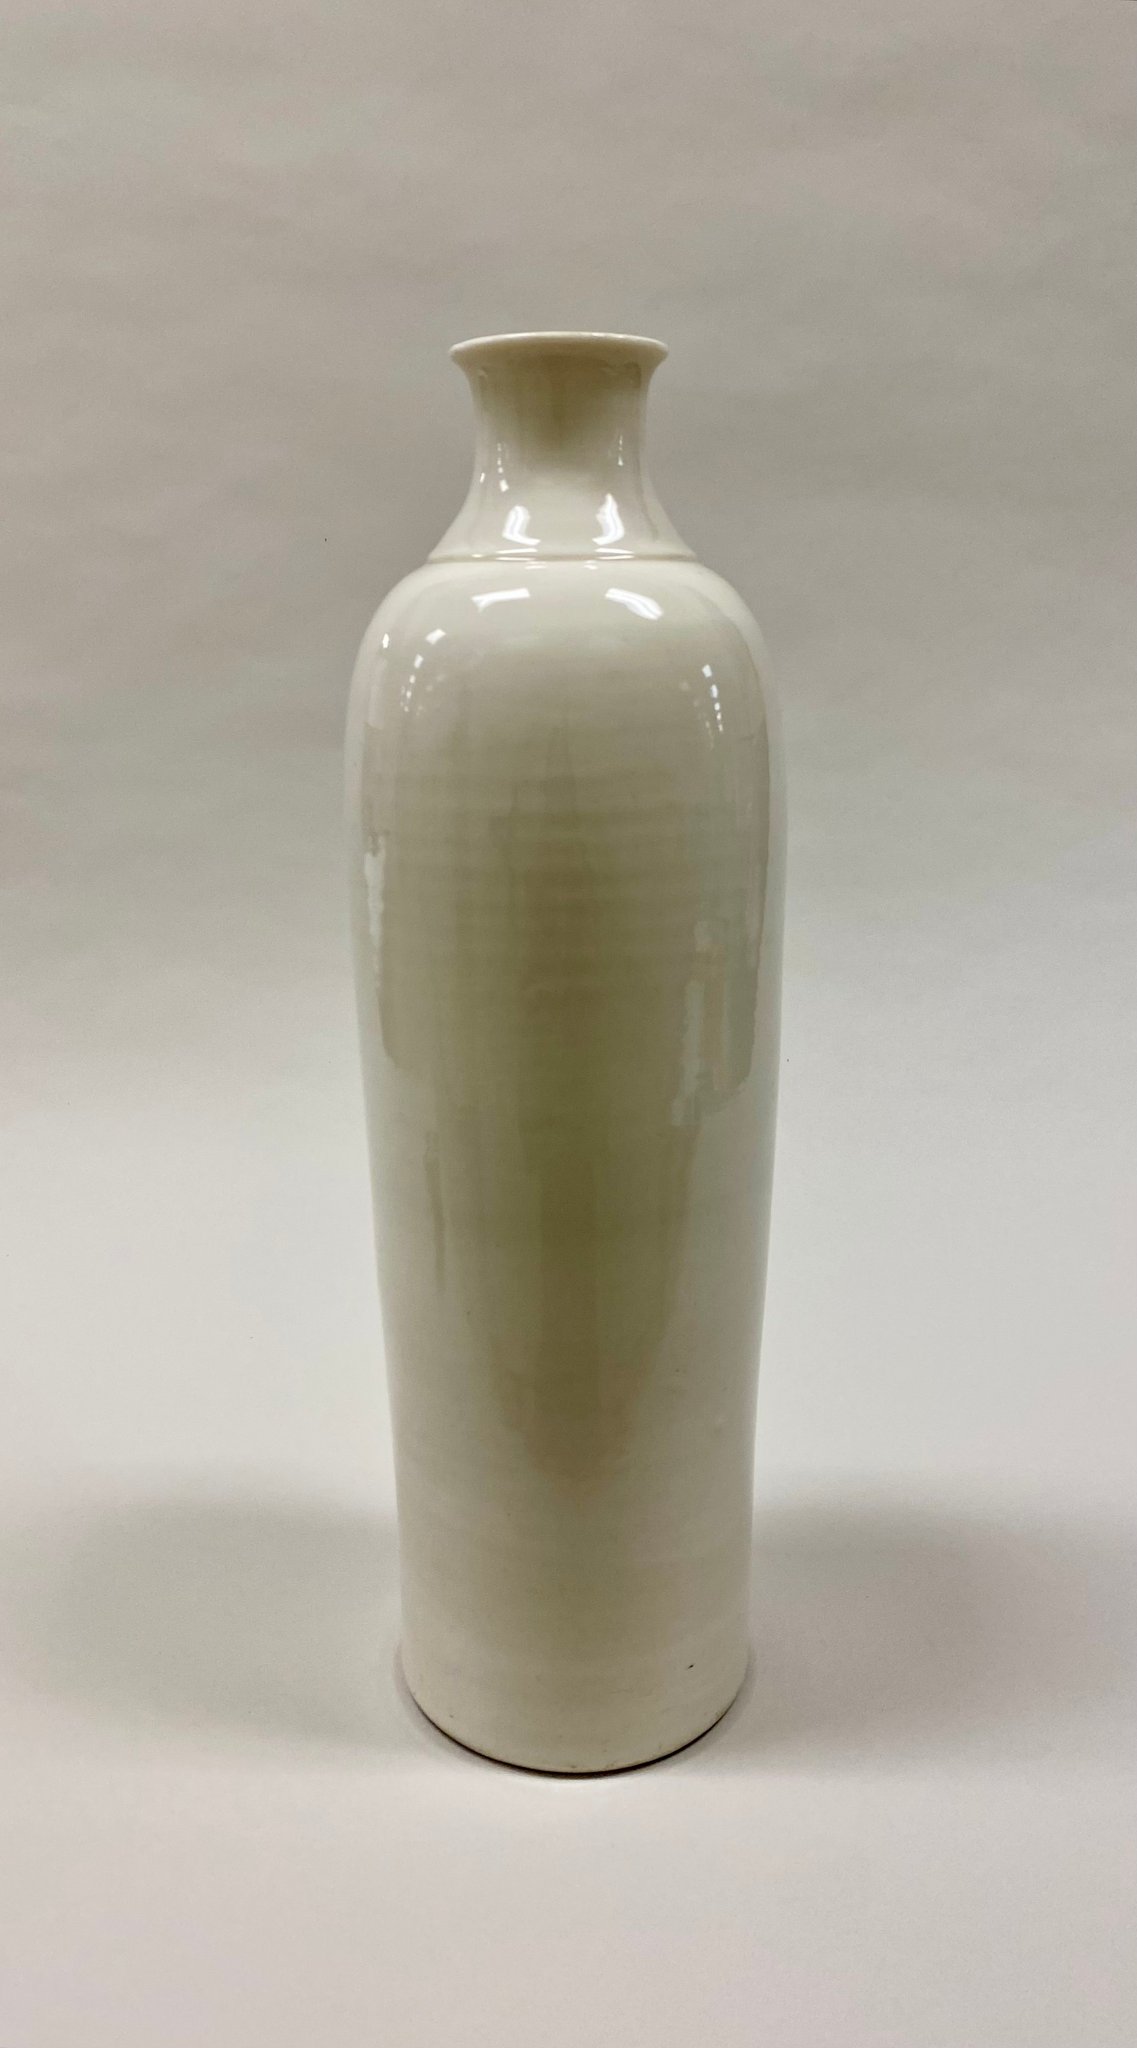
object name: vase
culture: chinese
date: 1567-1633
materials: glaze, porcelain